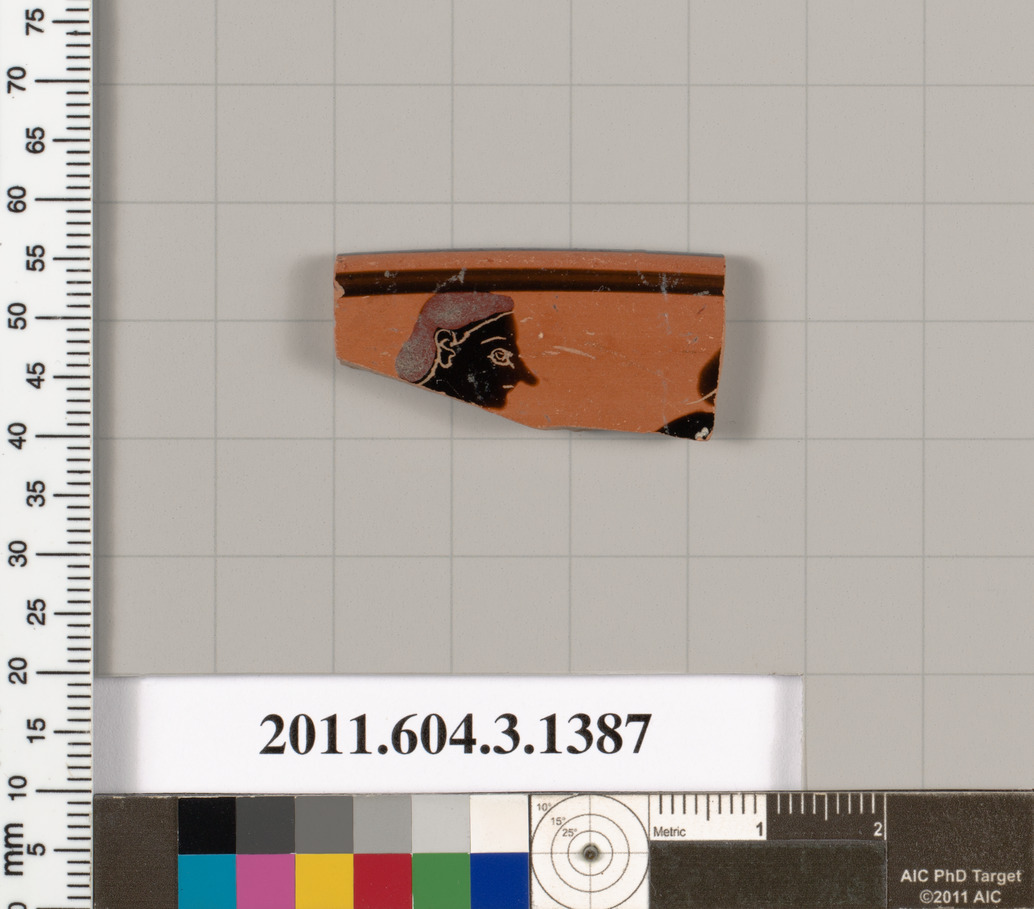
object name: skyphos fragment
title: Terracotta rim fragment of a skyphos (deep drinking cup)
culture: greek, attic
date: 534-468 BCE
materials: terracotta